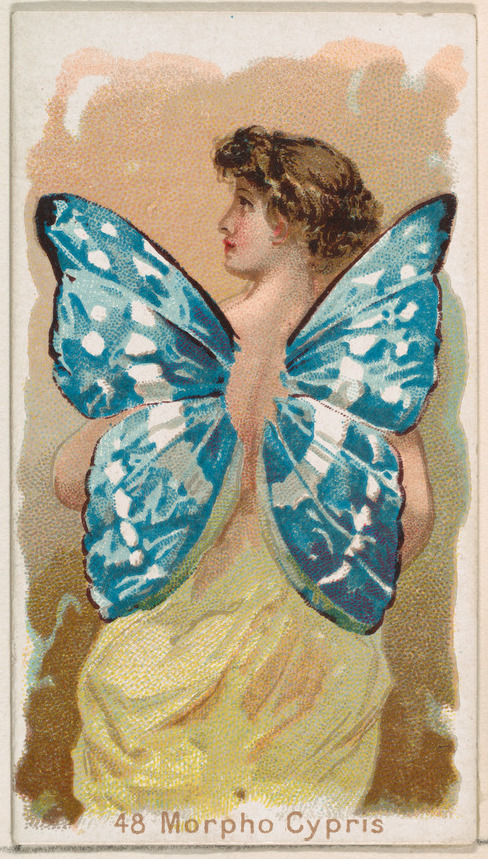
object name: print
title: Card 48, Morpho Cypris, from the Butterflies series (N183) issued by Wm. S. Kimball & Co.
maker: william s. kimball & company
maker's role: publisher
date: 1888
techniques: color lithograph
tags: profiles,women,butterflies